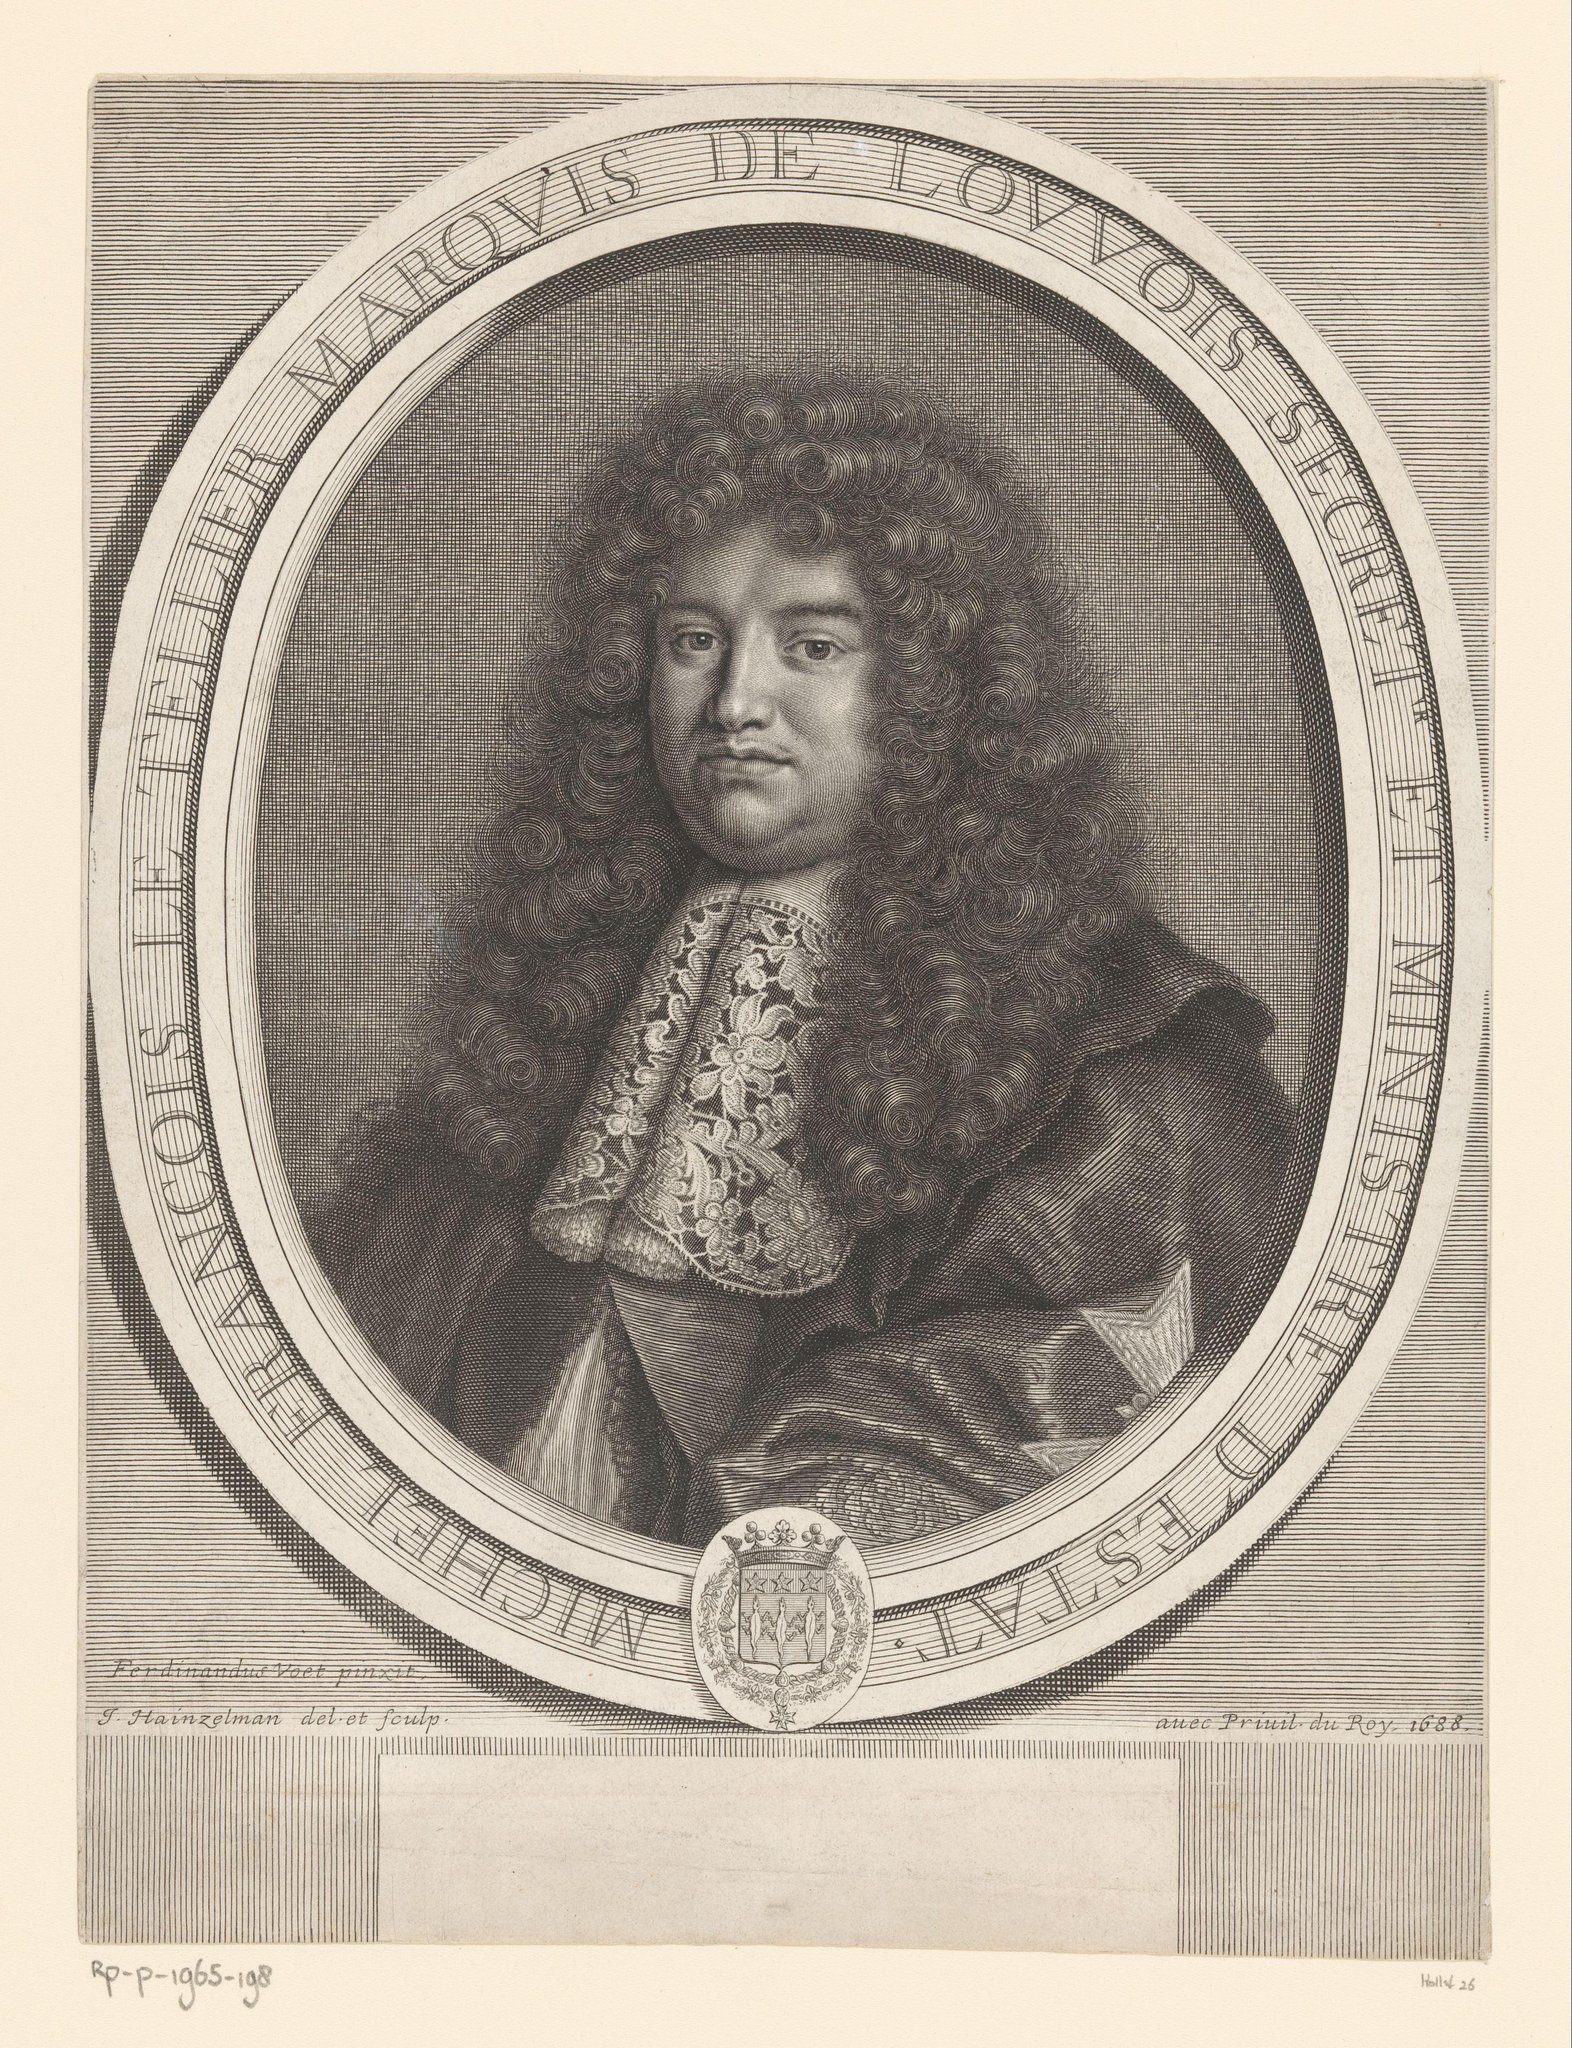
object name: print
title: Portret van François-Michel Le Tellier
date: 1688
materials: paper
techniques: engraving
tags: paris, françois-michel le tellier (markies de louvois), historical persons, politician, e.g. party leader, armorial bearing, heraldry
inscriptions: collector's mark: Lugt 2228, collector's mark: Lugt 2760